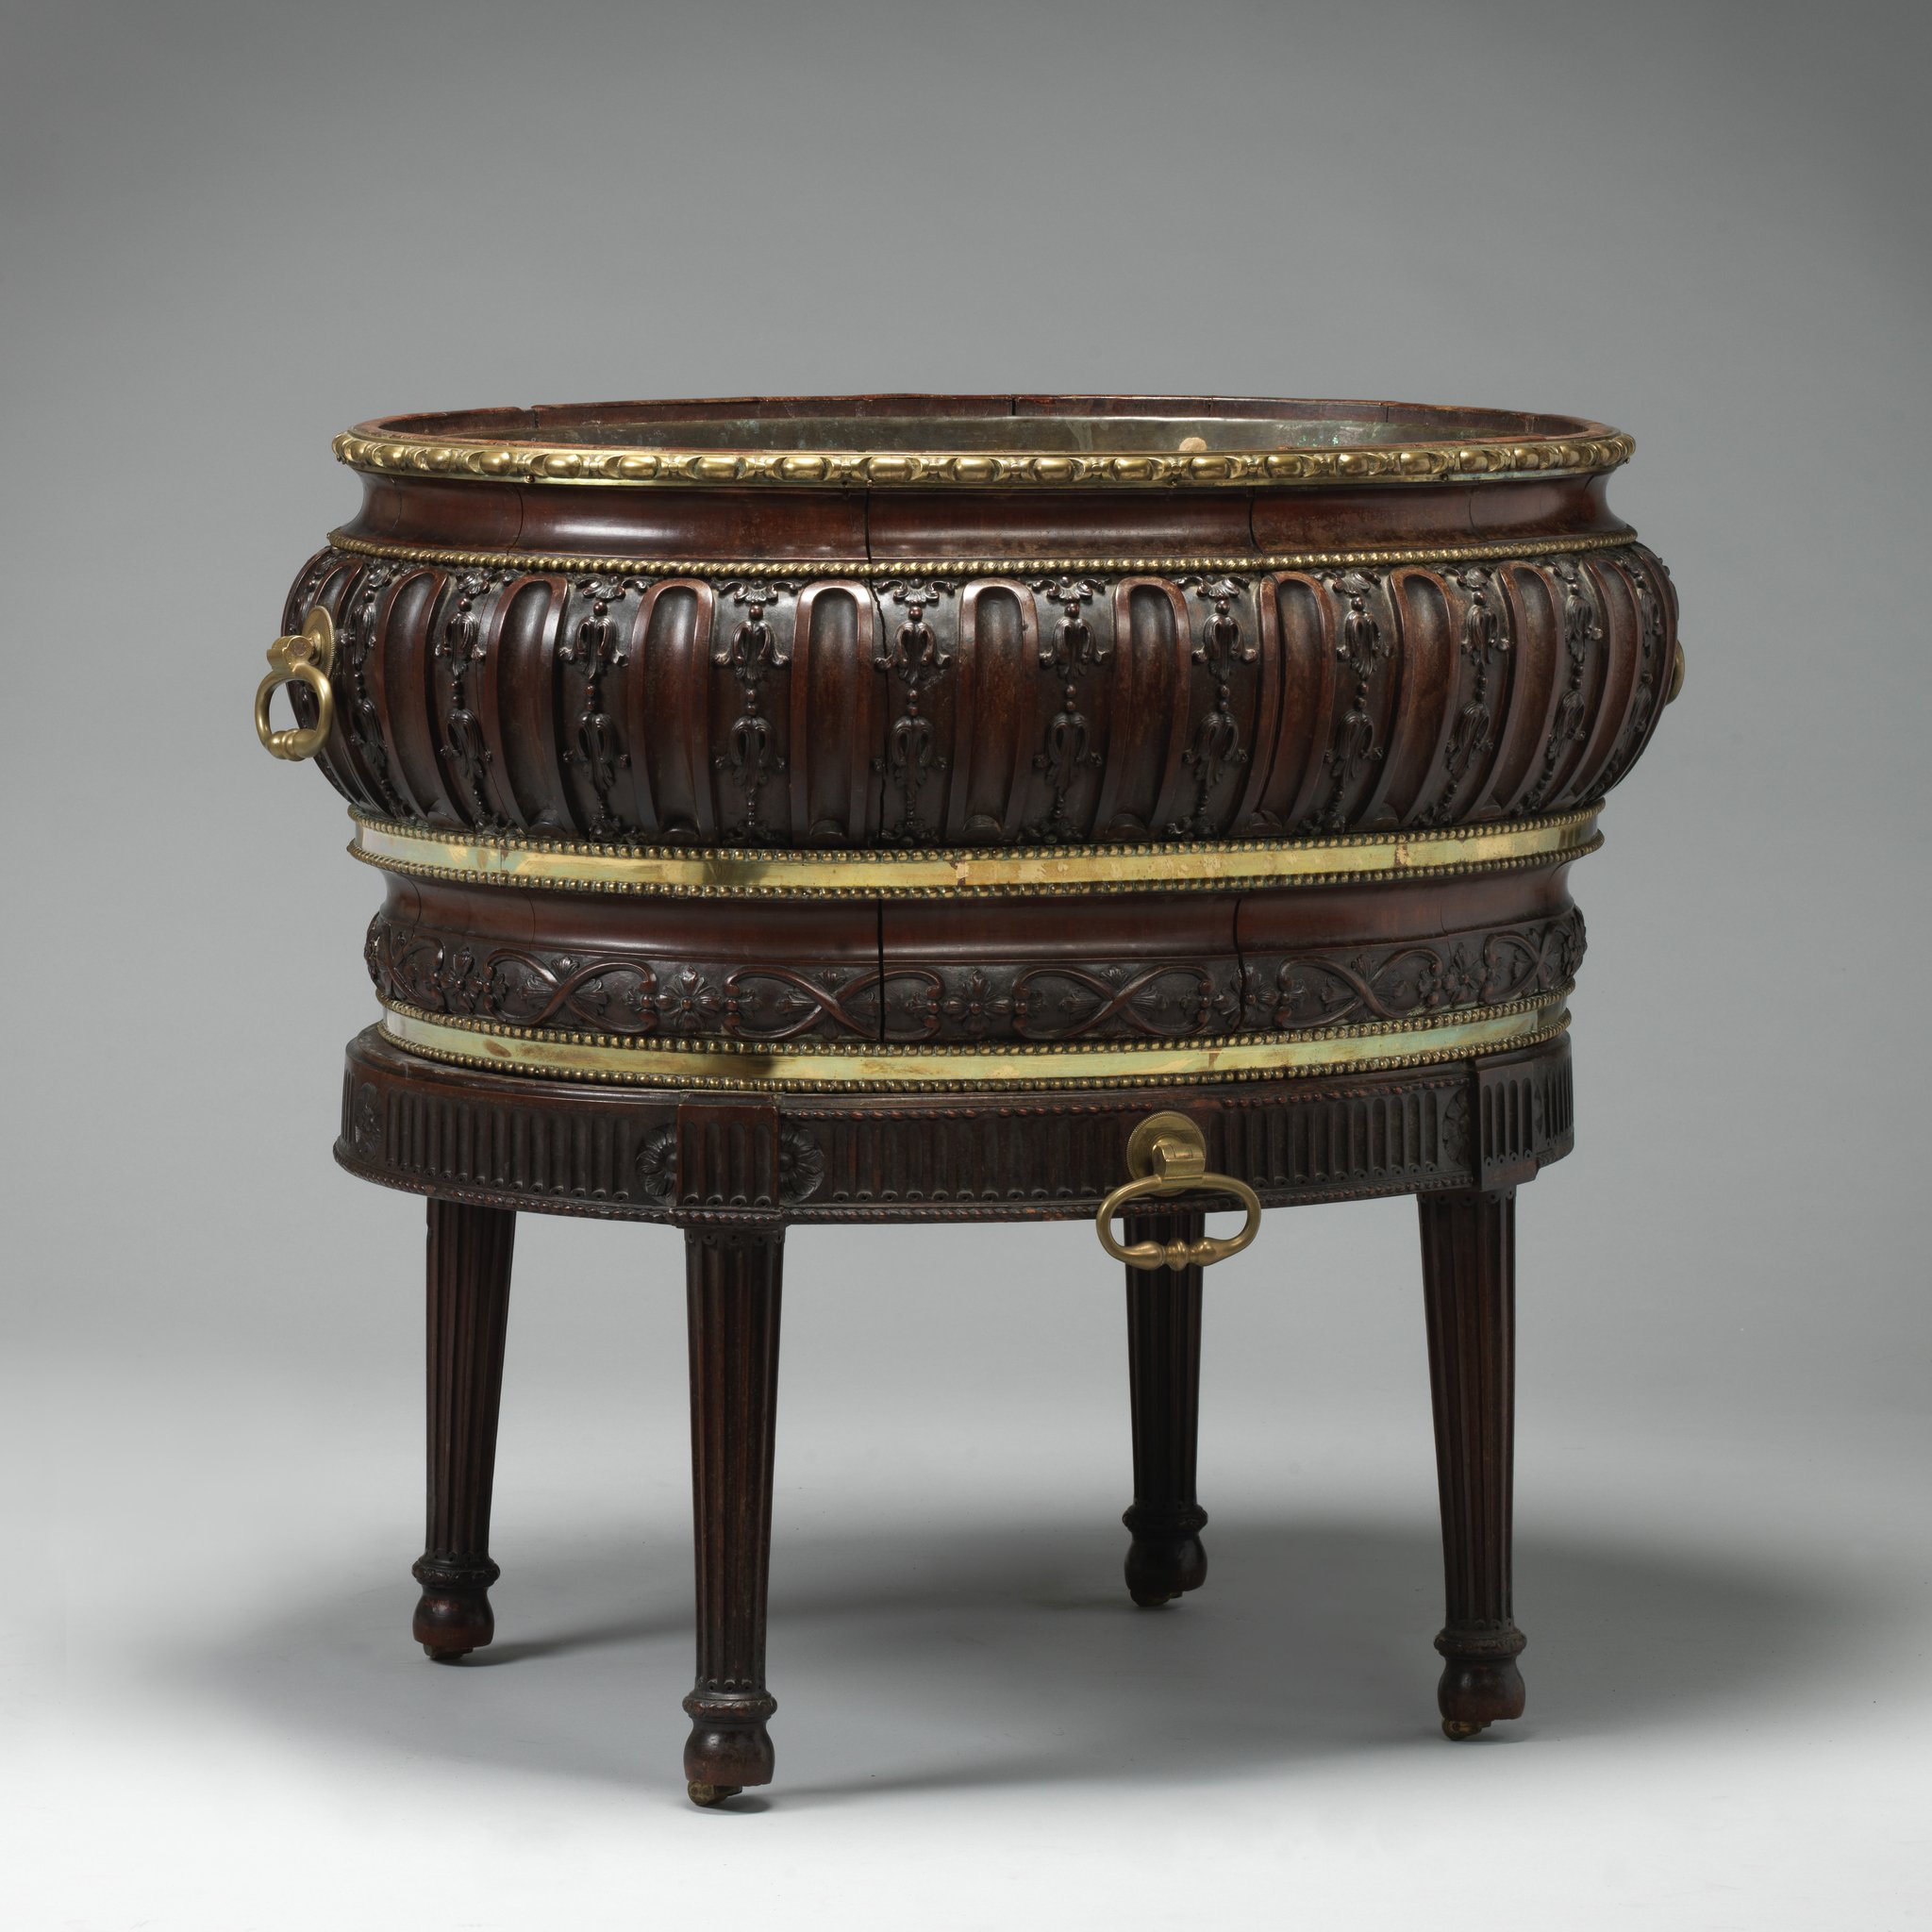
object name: wine cooler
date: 1770-1780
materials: wood